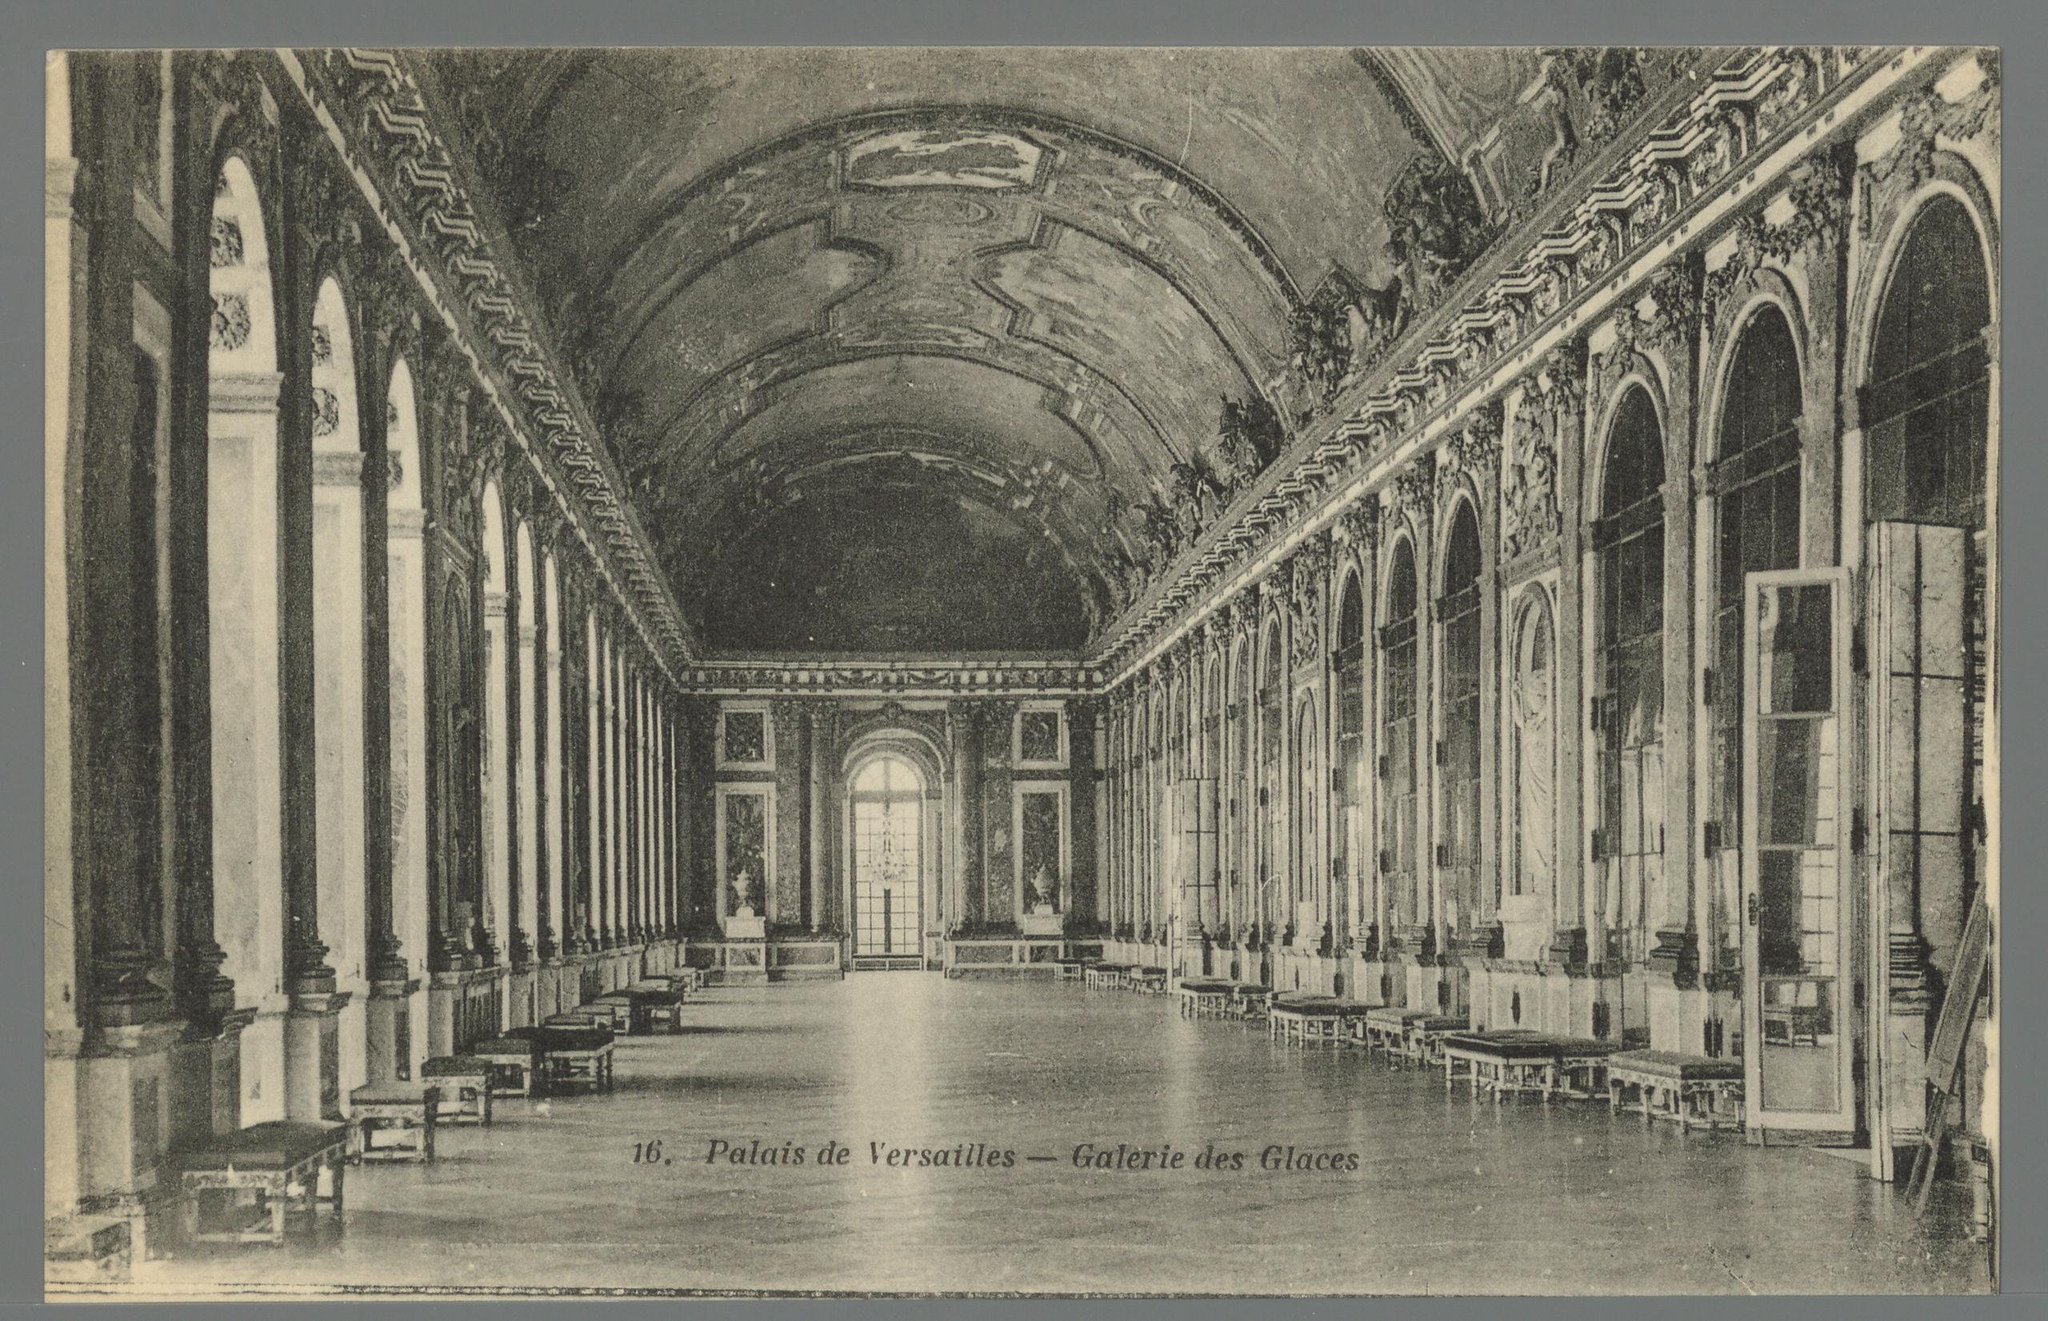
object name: photomechanical print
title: Palais de Versailles. Galerie des Glaces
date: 1903-1920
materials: cardboard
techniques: photograph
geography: versailles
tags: mirror, palace, interior ~ representation of a building